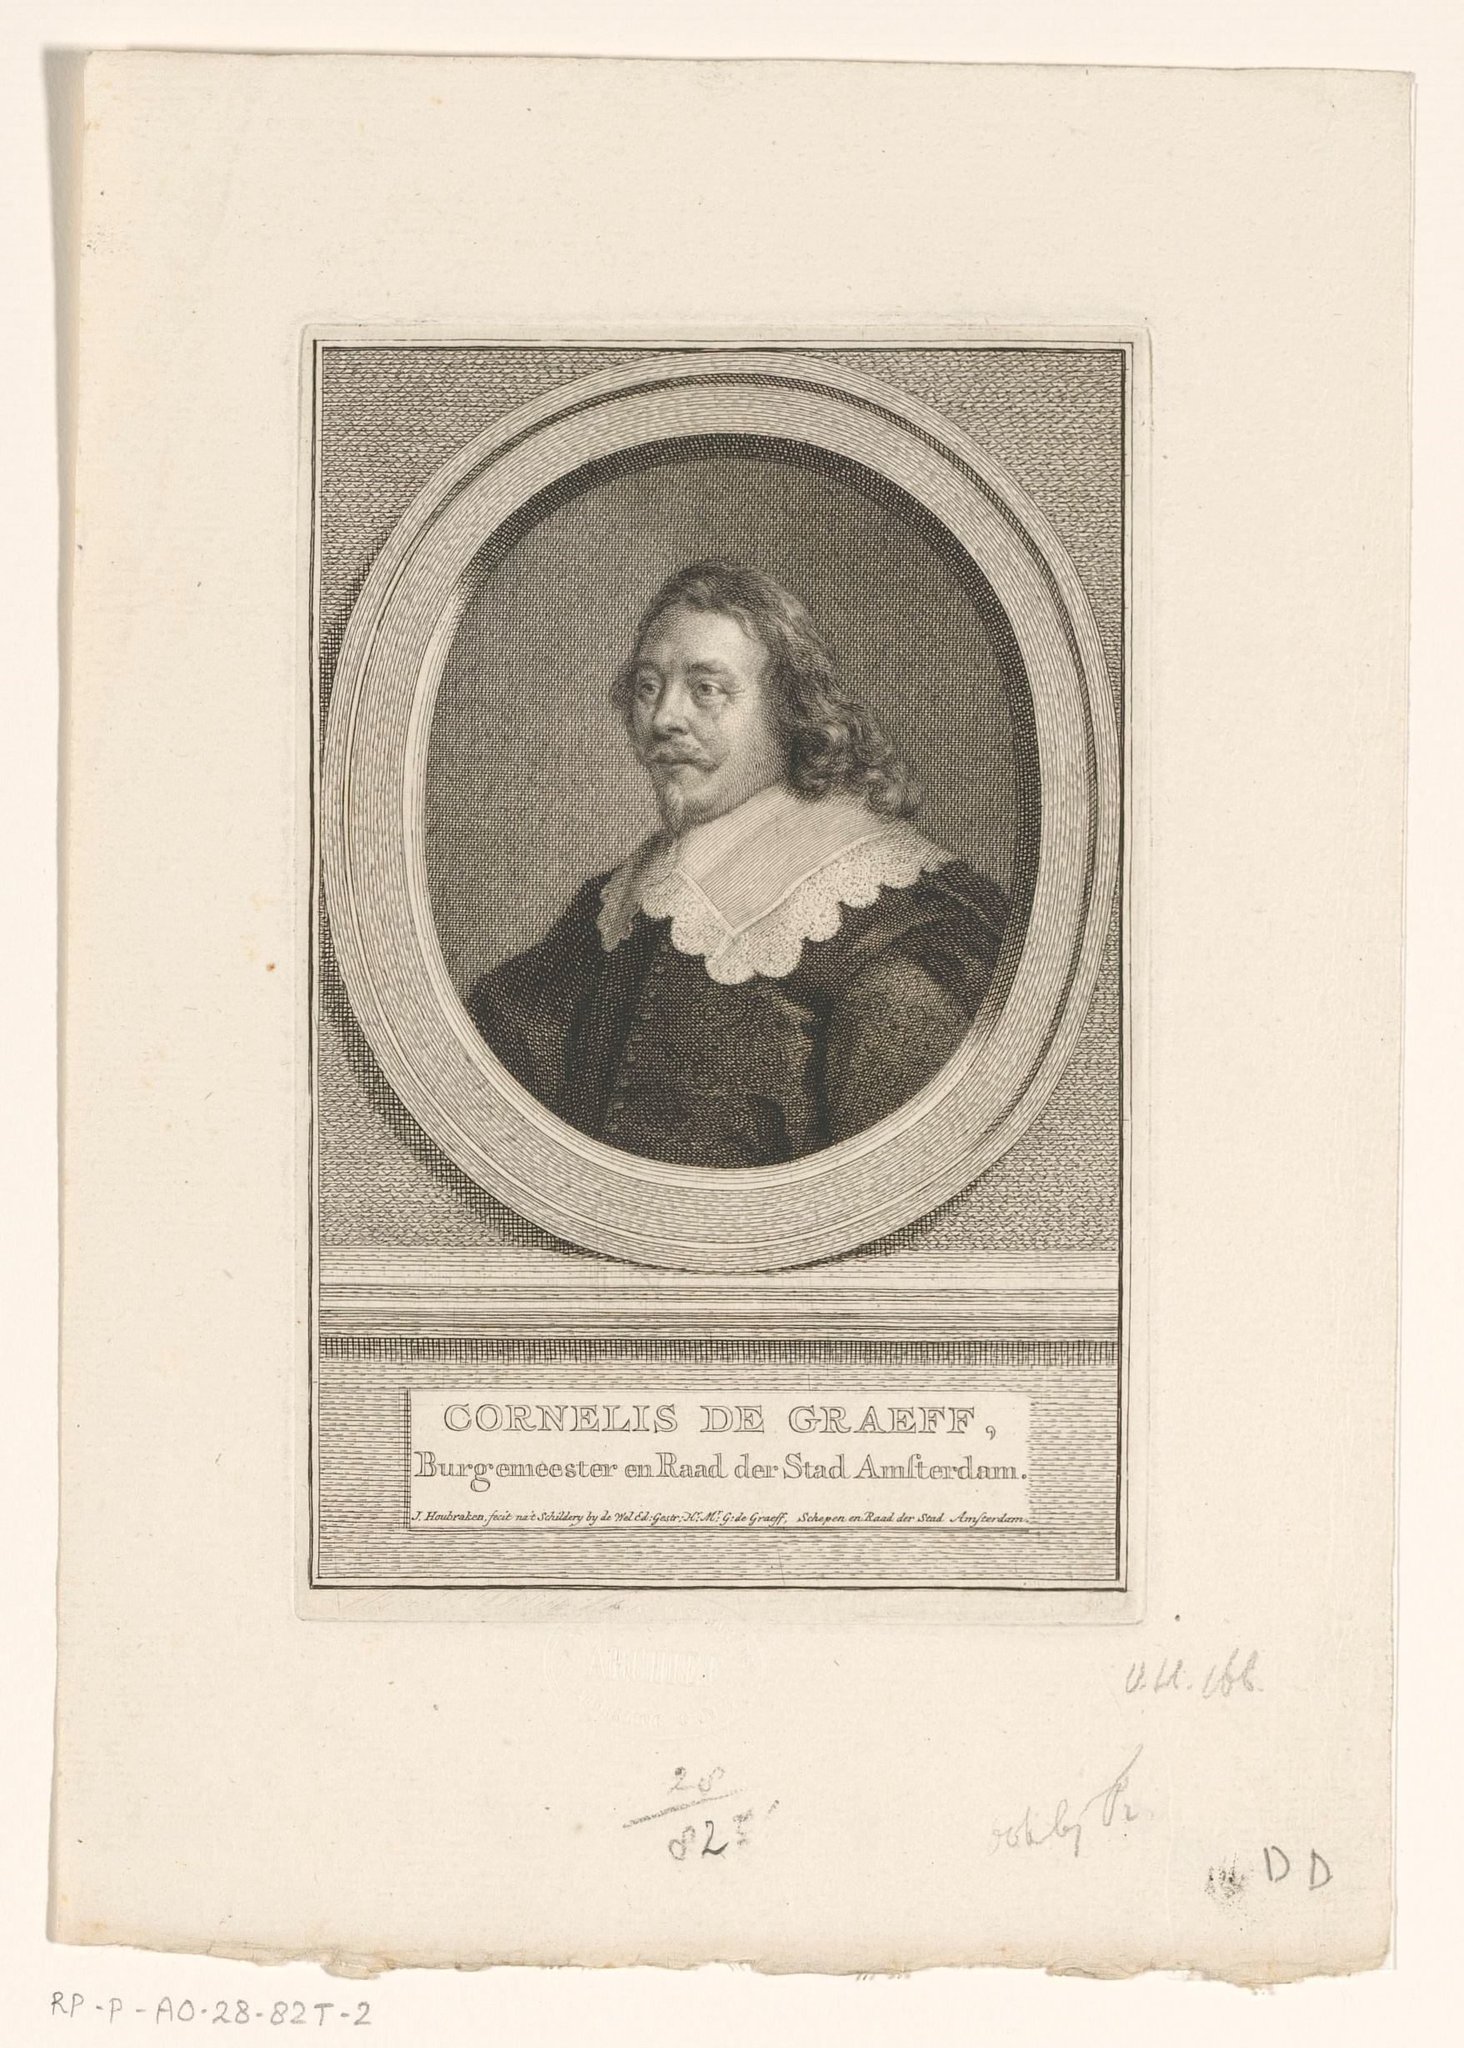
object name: print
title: Portret van Cornelis de Graeff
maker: jacob houbraken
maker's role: draughtsman, print maker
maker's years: 1698-1780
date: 1749-1780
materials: paper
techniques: engraving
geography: amsterdam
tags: cornelis de graeff, historical persons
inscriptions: collector's mark: Lugt 2228, check stamp: ‘Archief Ministerie van Oorlog Afdeeling Genie’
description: Deze prent is oorspronkelijk bedoeld als aanvulling op Jan Wagenaars ‘Vaderlandsche historie’* en was zo vanaf 1796 verkrijgbaar bij Johannes Allart te Amsterdam. Voor de advertentie waarin Allart de 60 portretten en 7 platen, allen gegraveerd door Houbraken, ter aanvulling op Wagenaars ‘Vaderlandsche historie’ aanbiedt, zie RP-P-OB-77.766. *Van dit werk zijn in de achttiende eeuw meerdere uitgaves verschenen, zoals: Wagenaar, Jan. Vaderlandsche historie, vervattende de geschiedenissen der Vereenigde Nederlanden (…). 21 delen. Amsterdam: Isaak Tirion, 1749-1759. Wagenaar, Jan. Vaderlandsche historie, vervattende de geschiedenissen der nu Vereenigde Nederlanden (…). 21 delen. Amsterdam: weduwe Isaak Tirion, 1770. Wagenaar, Jan. Vaderlandsche historie, vervattende de geschiedenissen der nu Vereenigde Nederlanden (…). 21 delen. Amsterdam, Leiden, Dordrecht en Harlingen: P. Schouten e.a., 1782. Wagenaar, Jan. Vaderlandsche historie, vervattende de geschiedenissen der nu Vereenigde Nederlanden (…). 21 delen. Amsterdam: Johannes Allart, 1790-1796.